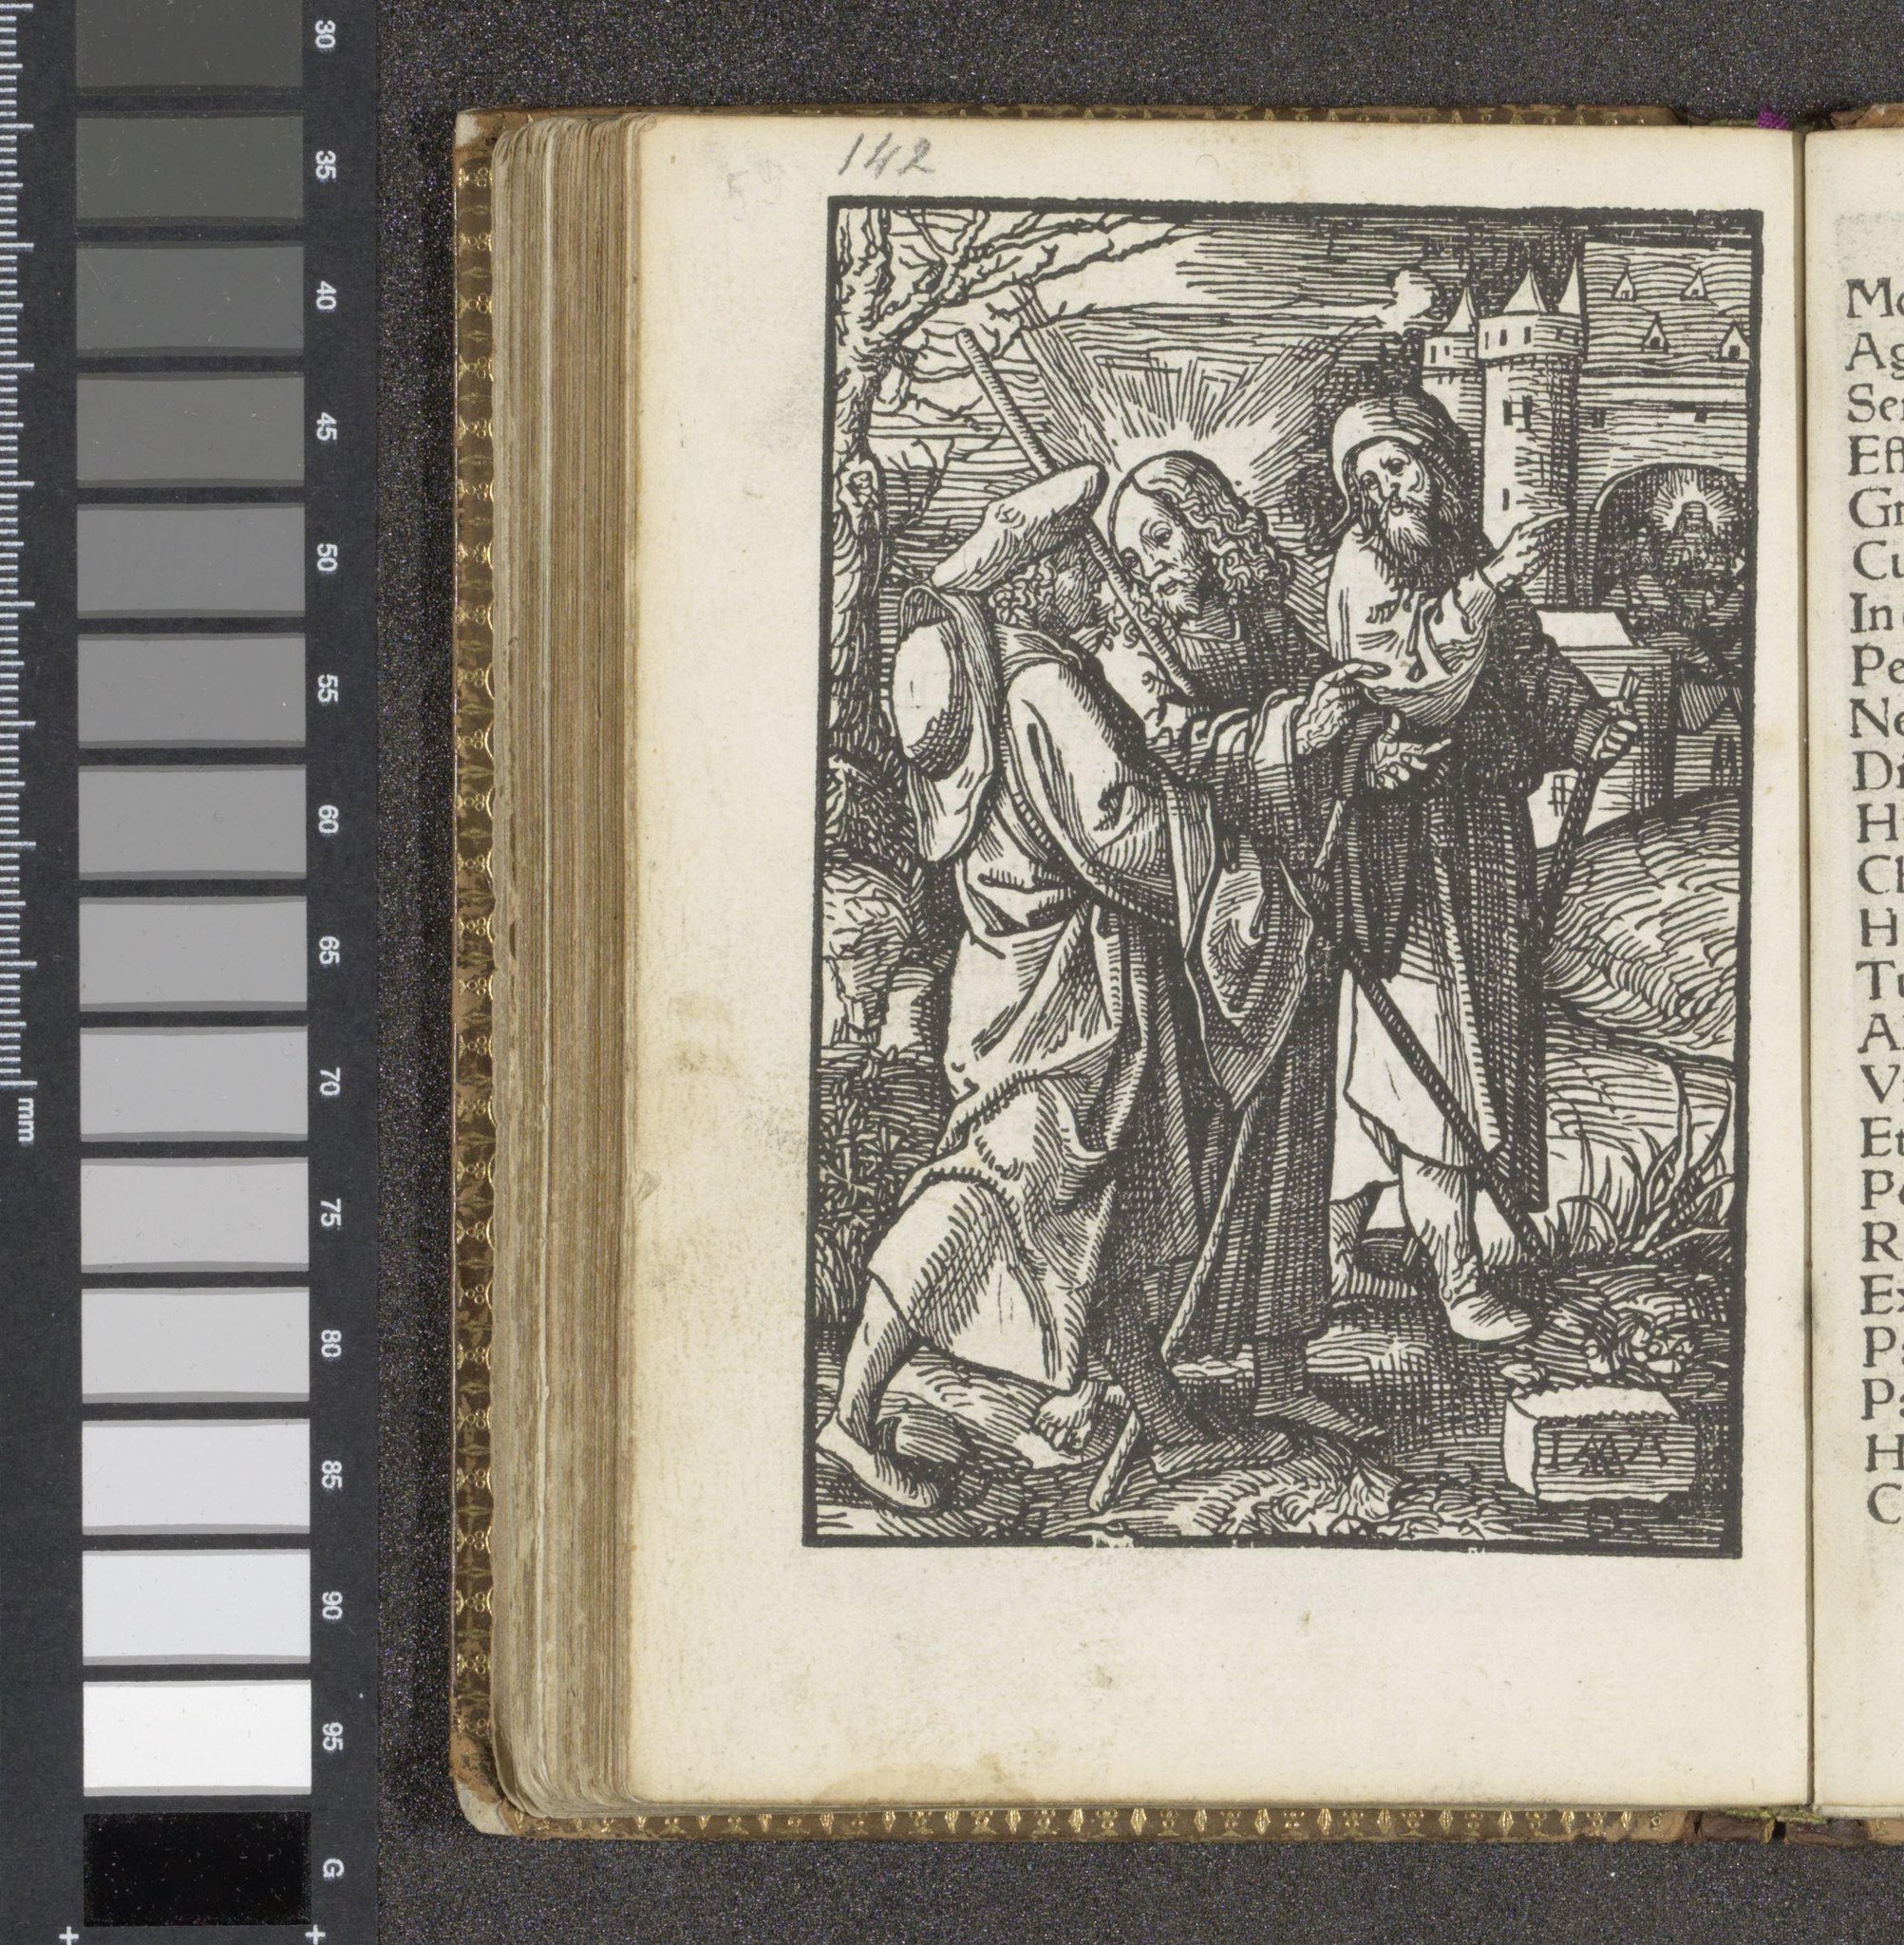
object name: print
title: De kleine Passie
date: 1523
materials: paper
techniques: woodcut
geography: amsterdam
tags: cleopas and peter arrive at the gate of emmaus, or at the inn; christ is asked to stay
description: De opgestane Christus ontmoet twee leerlingen en loopt met hen mee naar het dorp Emmaüs. Zij herkennen Christus niet. Een van de mannen wijst op het dorp Emmaüs. Prent maakt deel uit van een boek.